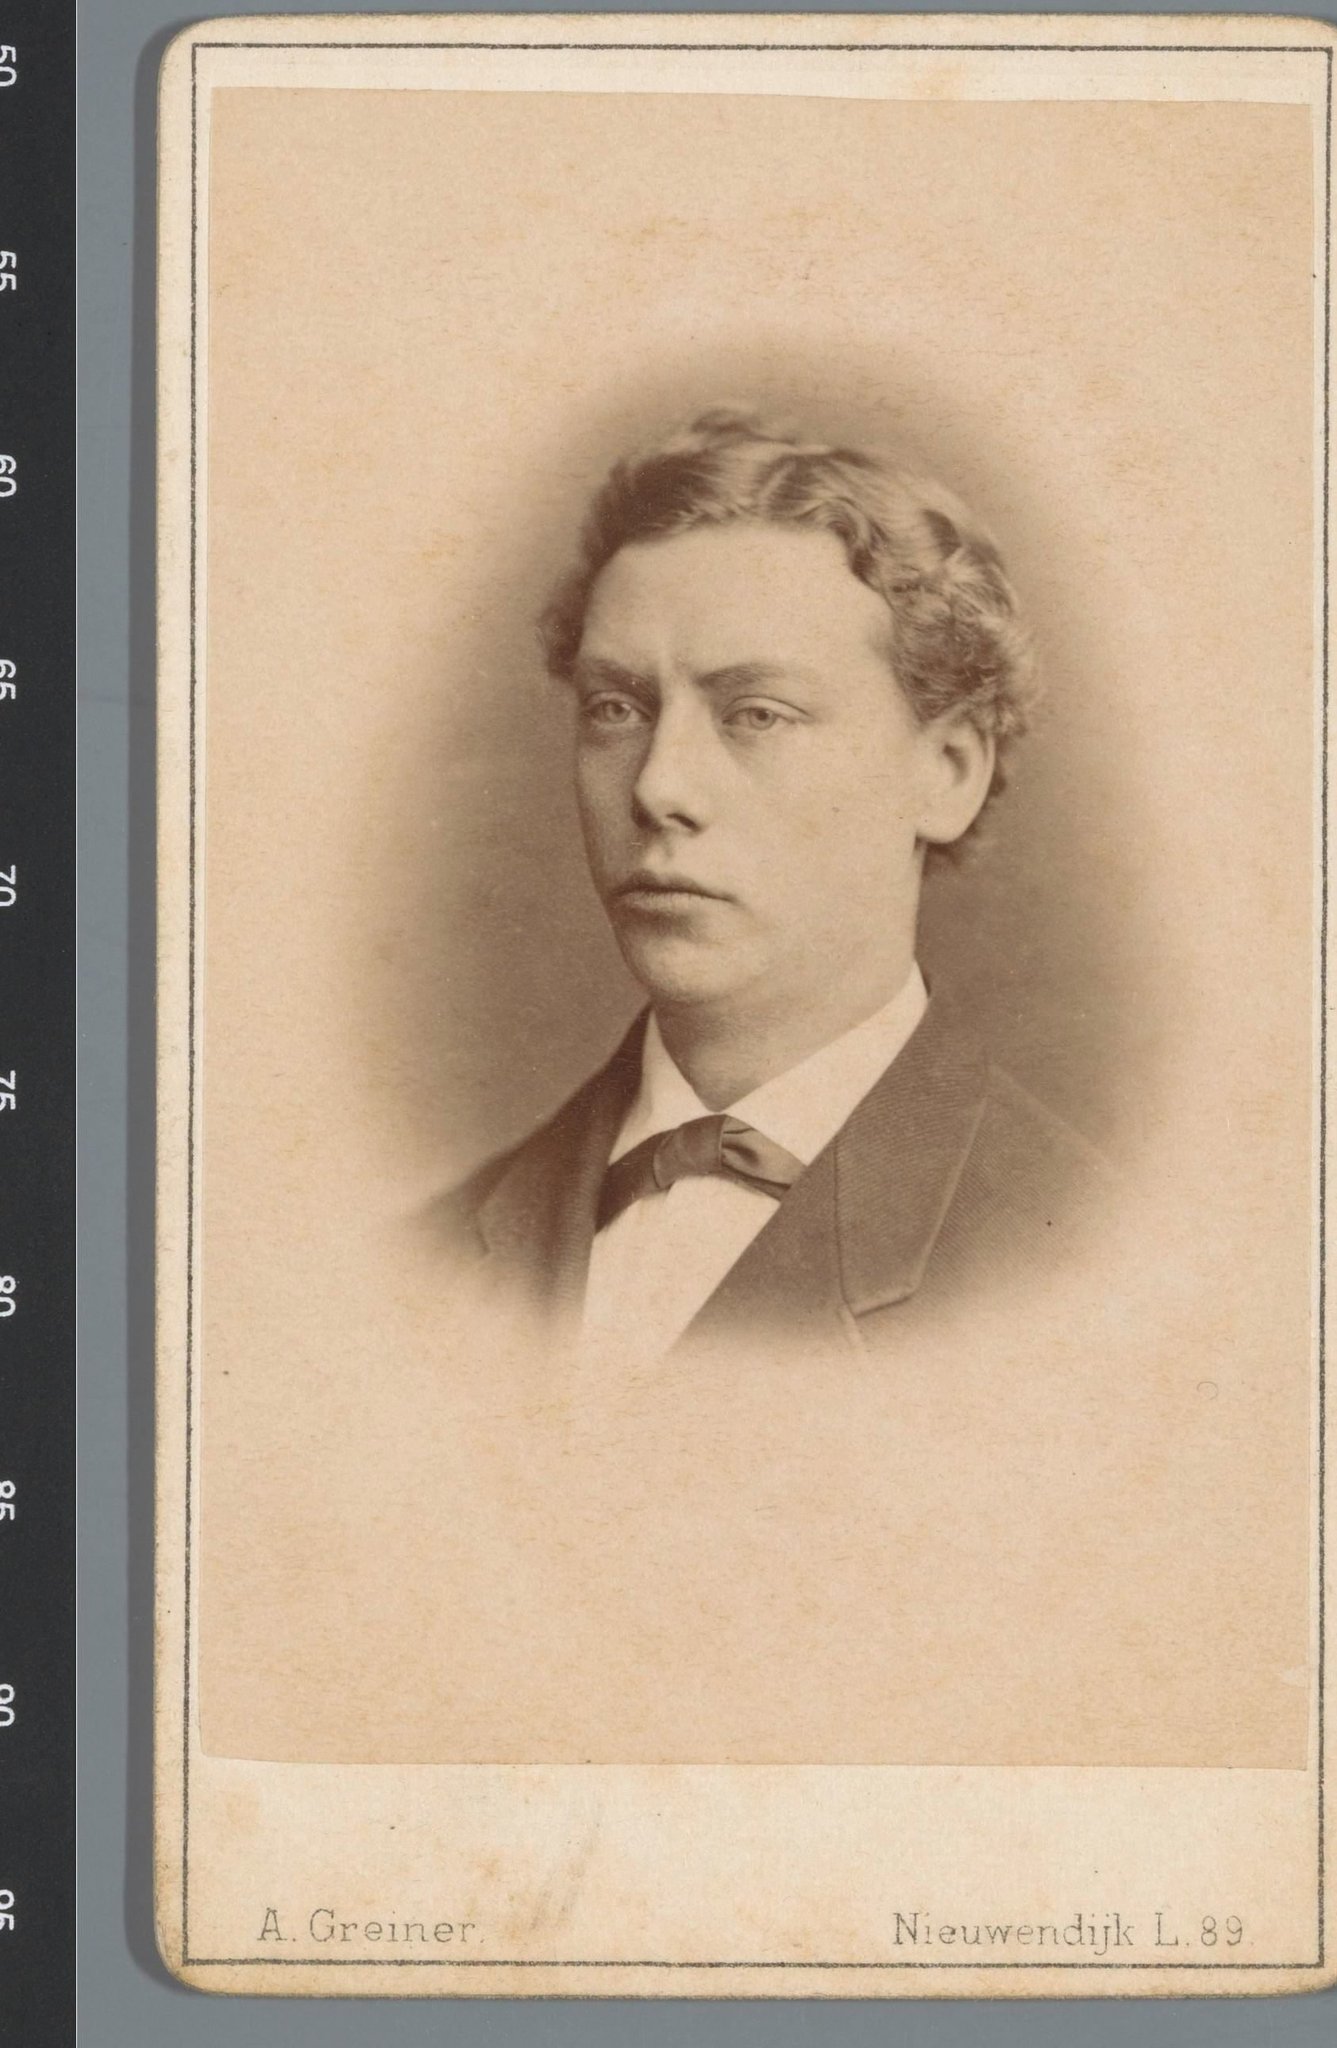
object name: carte de visite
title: Portret van een onbekende man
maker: albert greiner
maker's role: fotograaf, fotostudio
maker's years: 1833-1890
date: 1874-1897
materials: cardboard, paper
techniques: albumen print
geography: amsterdam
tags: historical persons, youth, adolescent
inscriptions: inscription: ‘4’, inscription: ‘AG/ A. GREINER/ Photograf/ AMSTERDAM/ NIEUWENDIJK L. 89.’